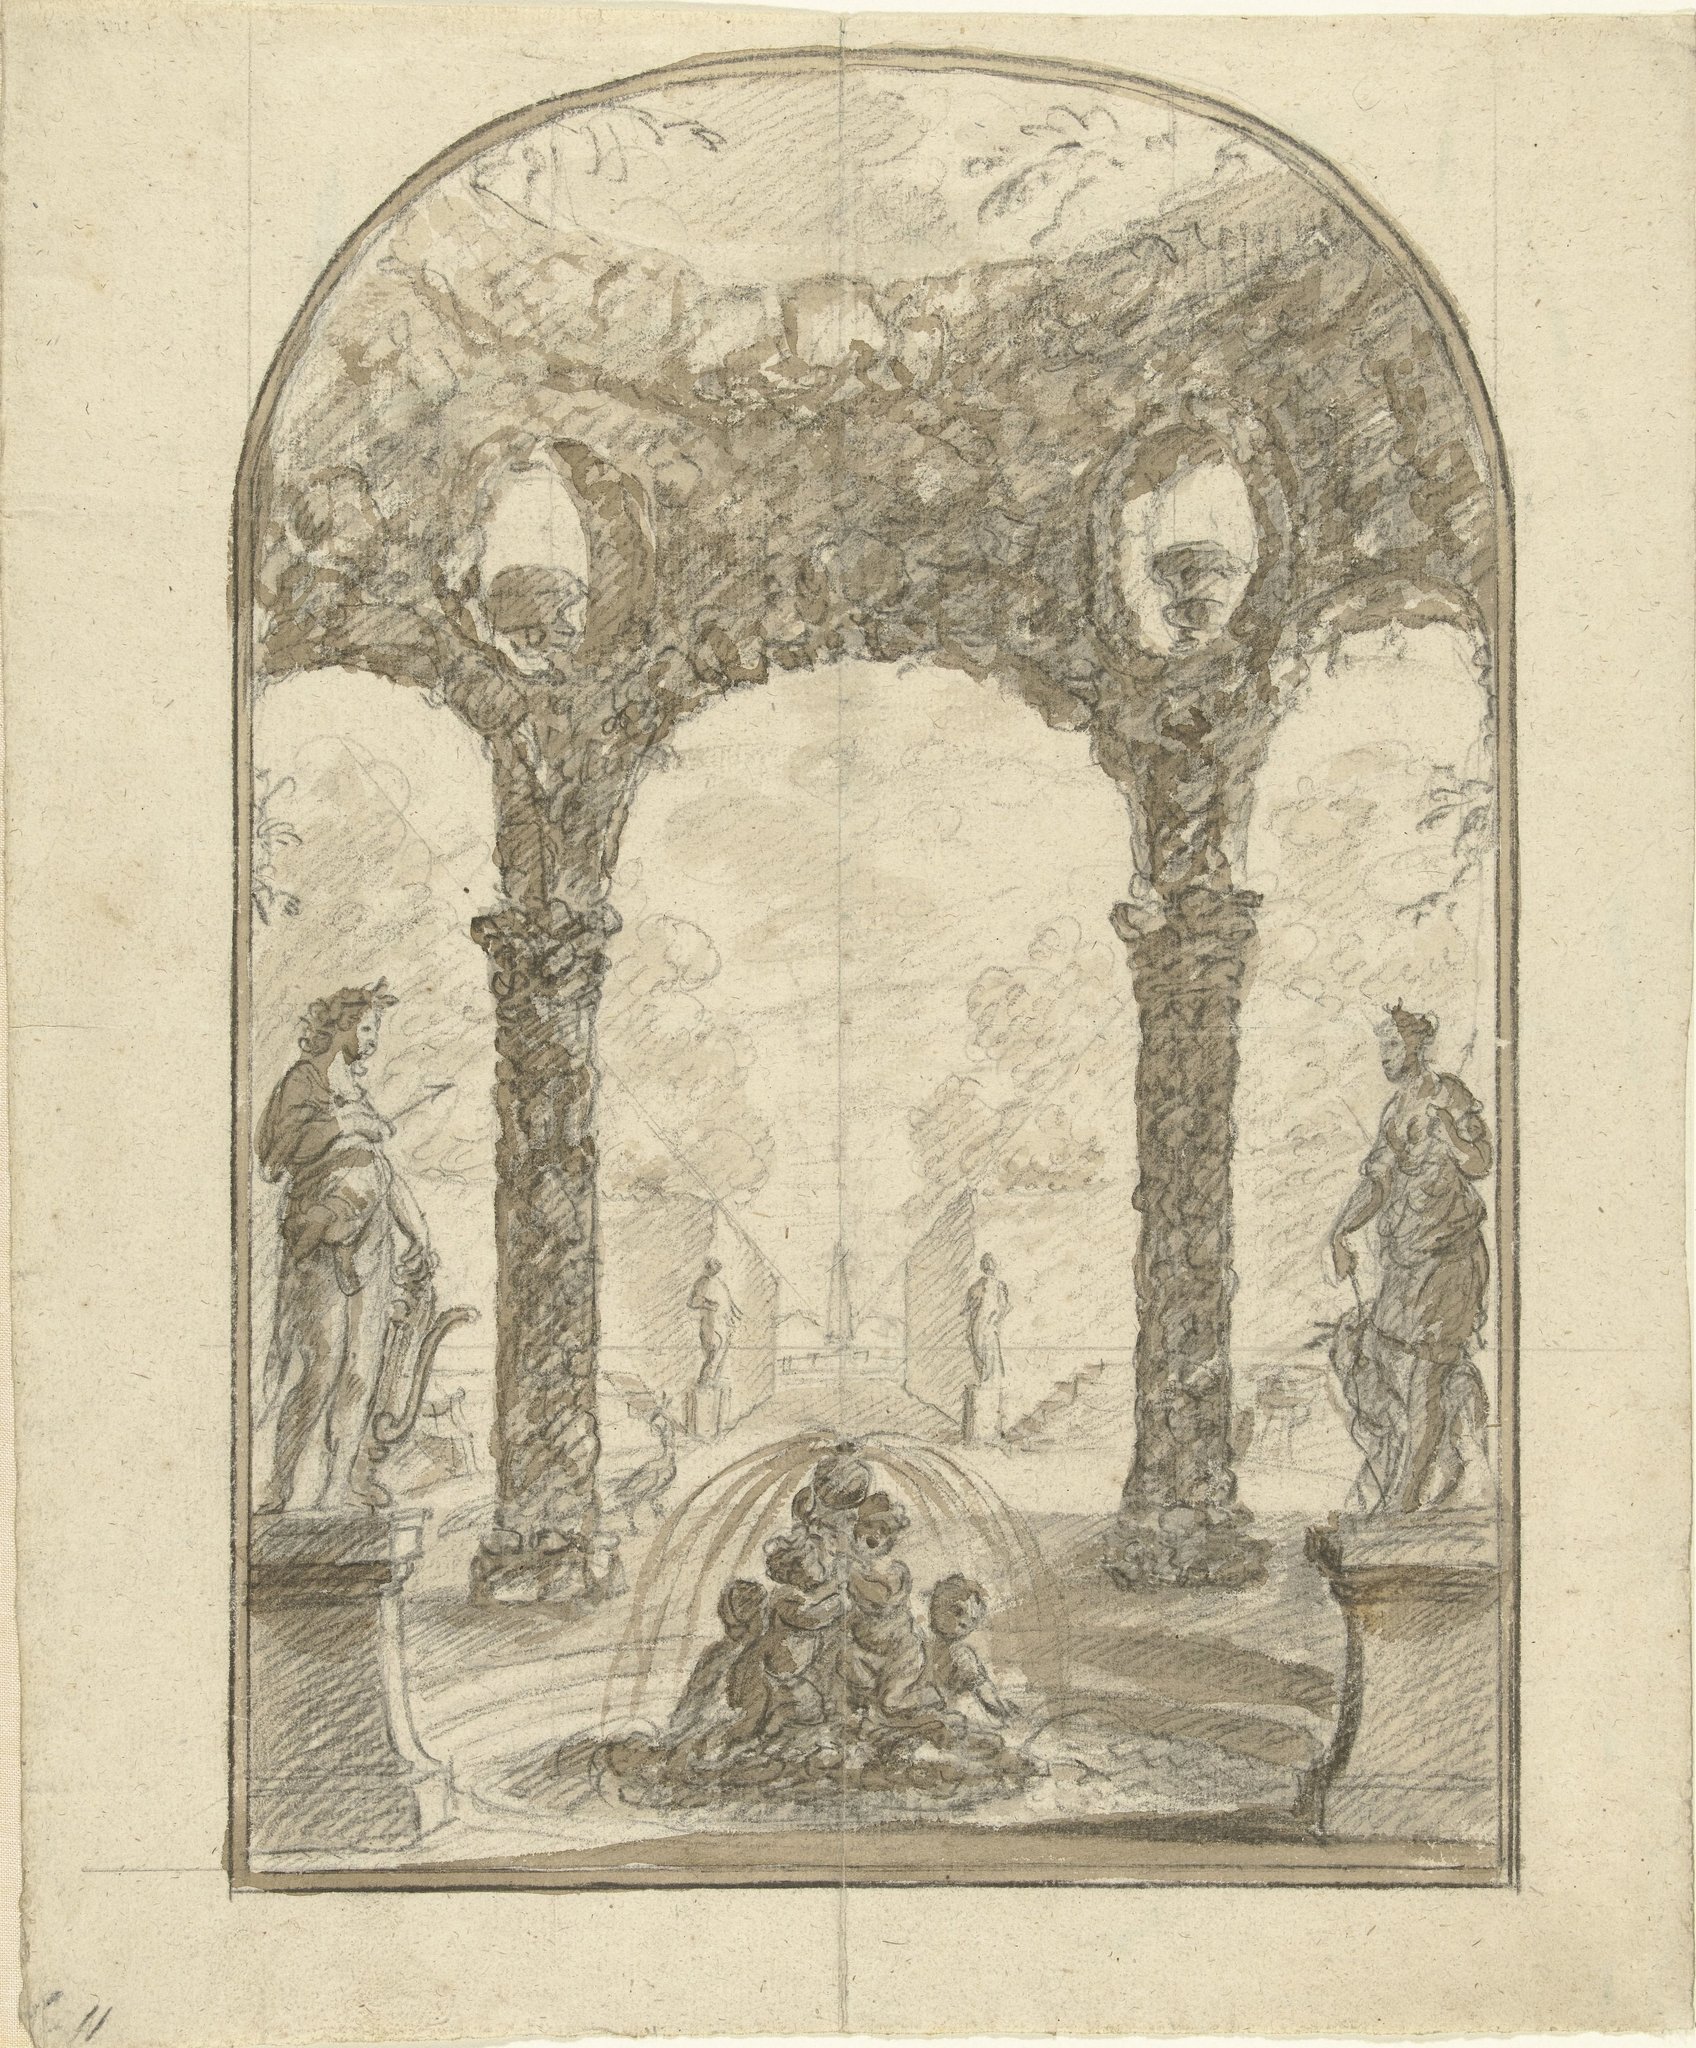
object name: drawing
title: Gezicht in een tuin met een fontein waarbij beelden van Apollo en Diana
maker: elias van nijmegen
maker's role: draughtsman, painter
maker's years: 1667-1755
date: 1677-1755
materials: chalk, paper, pencil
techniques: brush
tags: (story of) diana (artemis), (story of) apollo (phoebus), garden, statues, sculptures in garden